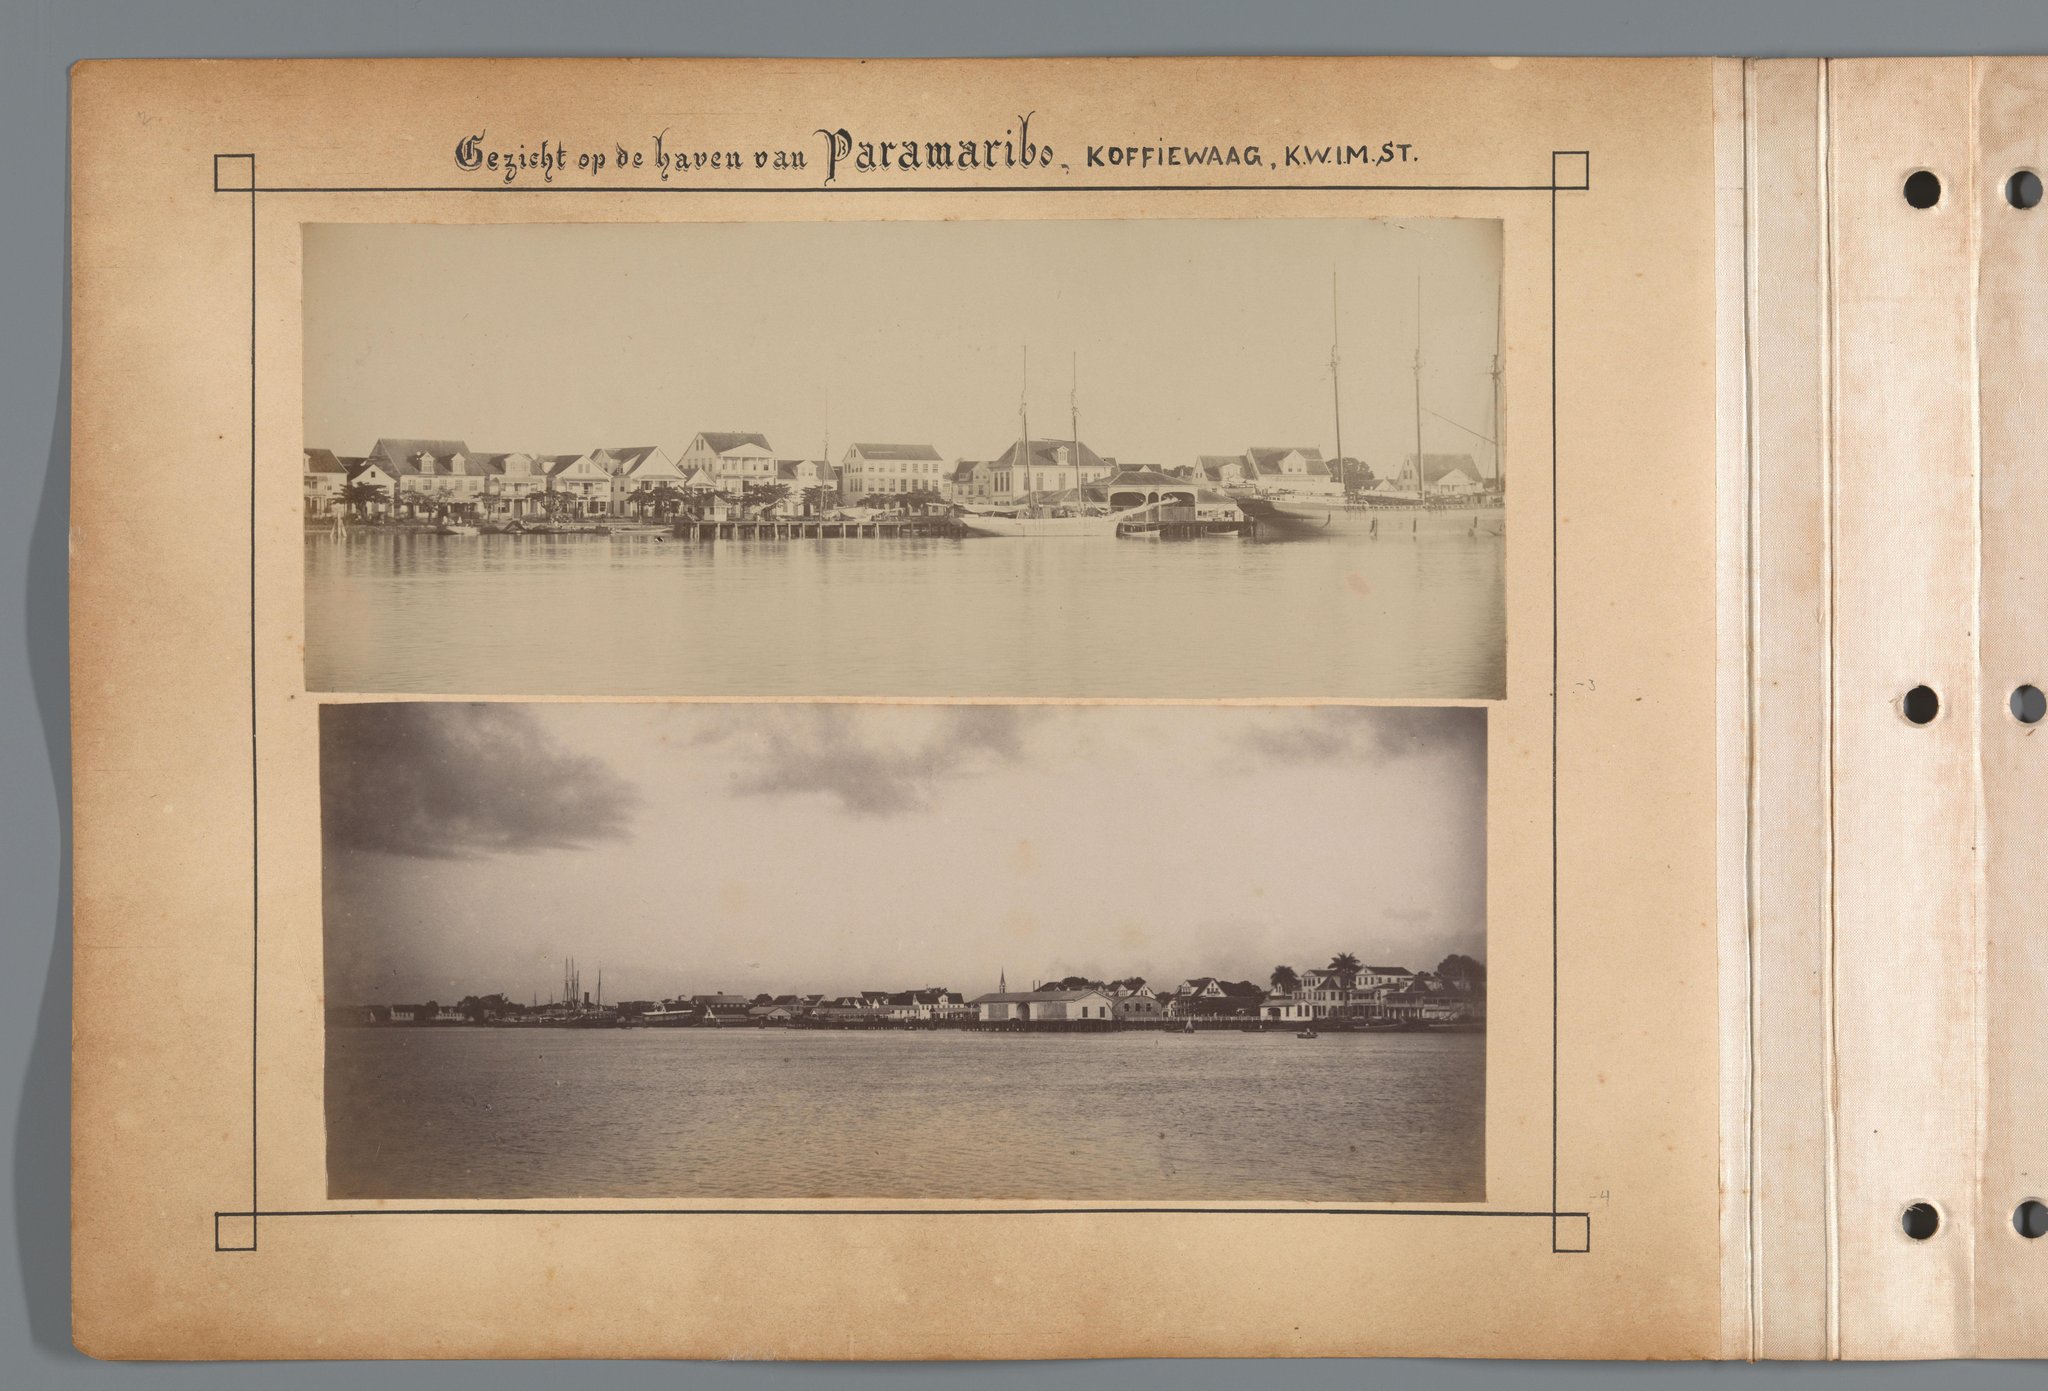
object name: photograph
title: Gezicht op de haven van Paramaribo, Koffiewaag, K.W.I.M..ST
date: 1898-1902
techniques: albumen print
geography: suriname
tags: suriname